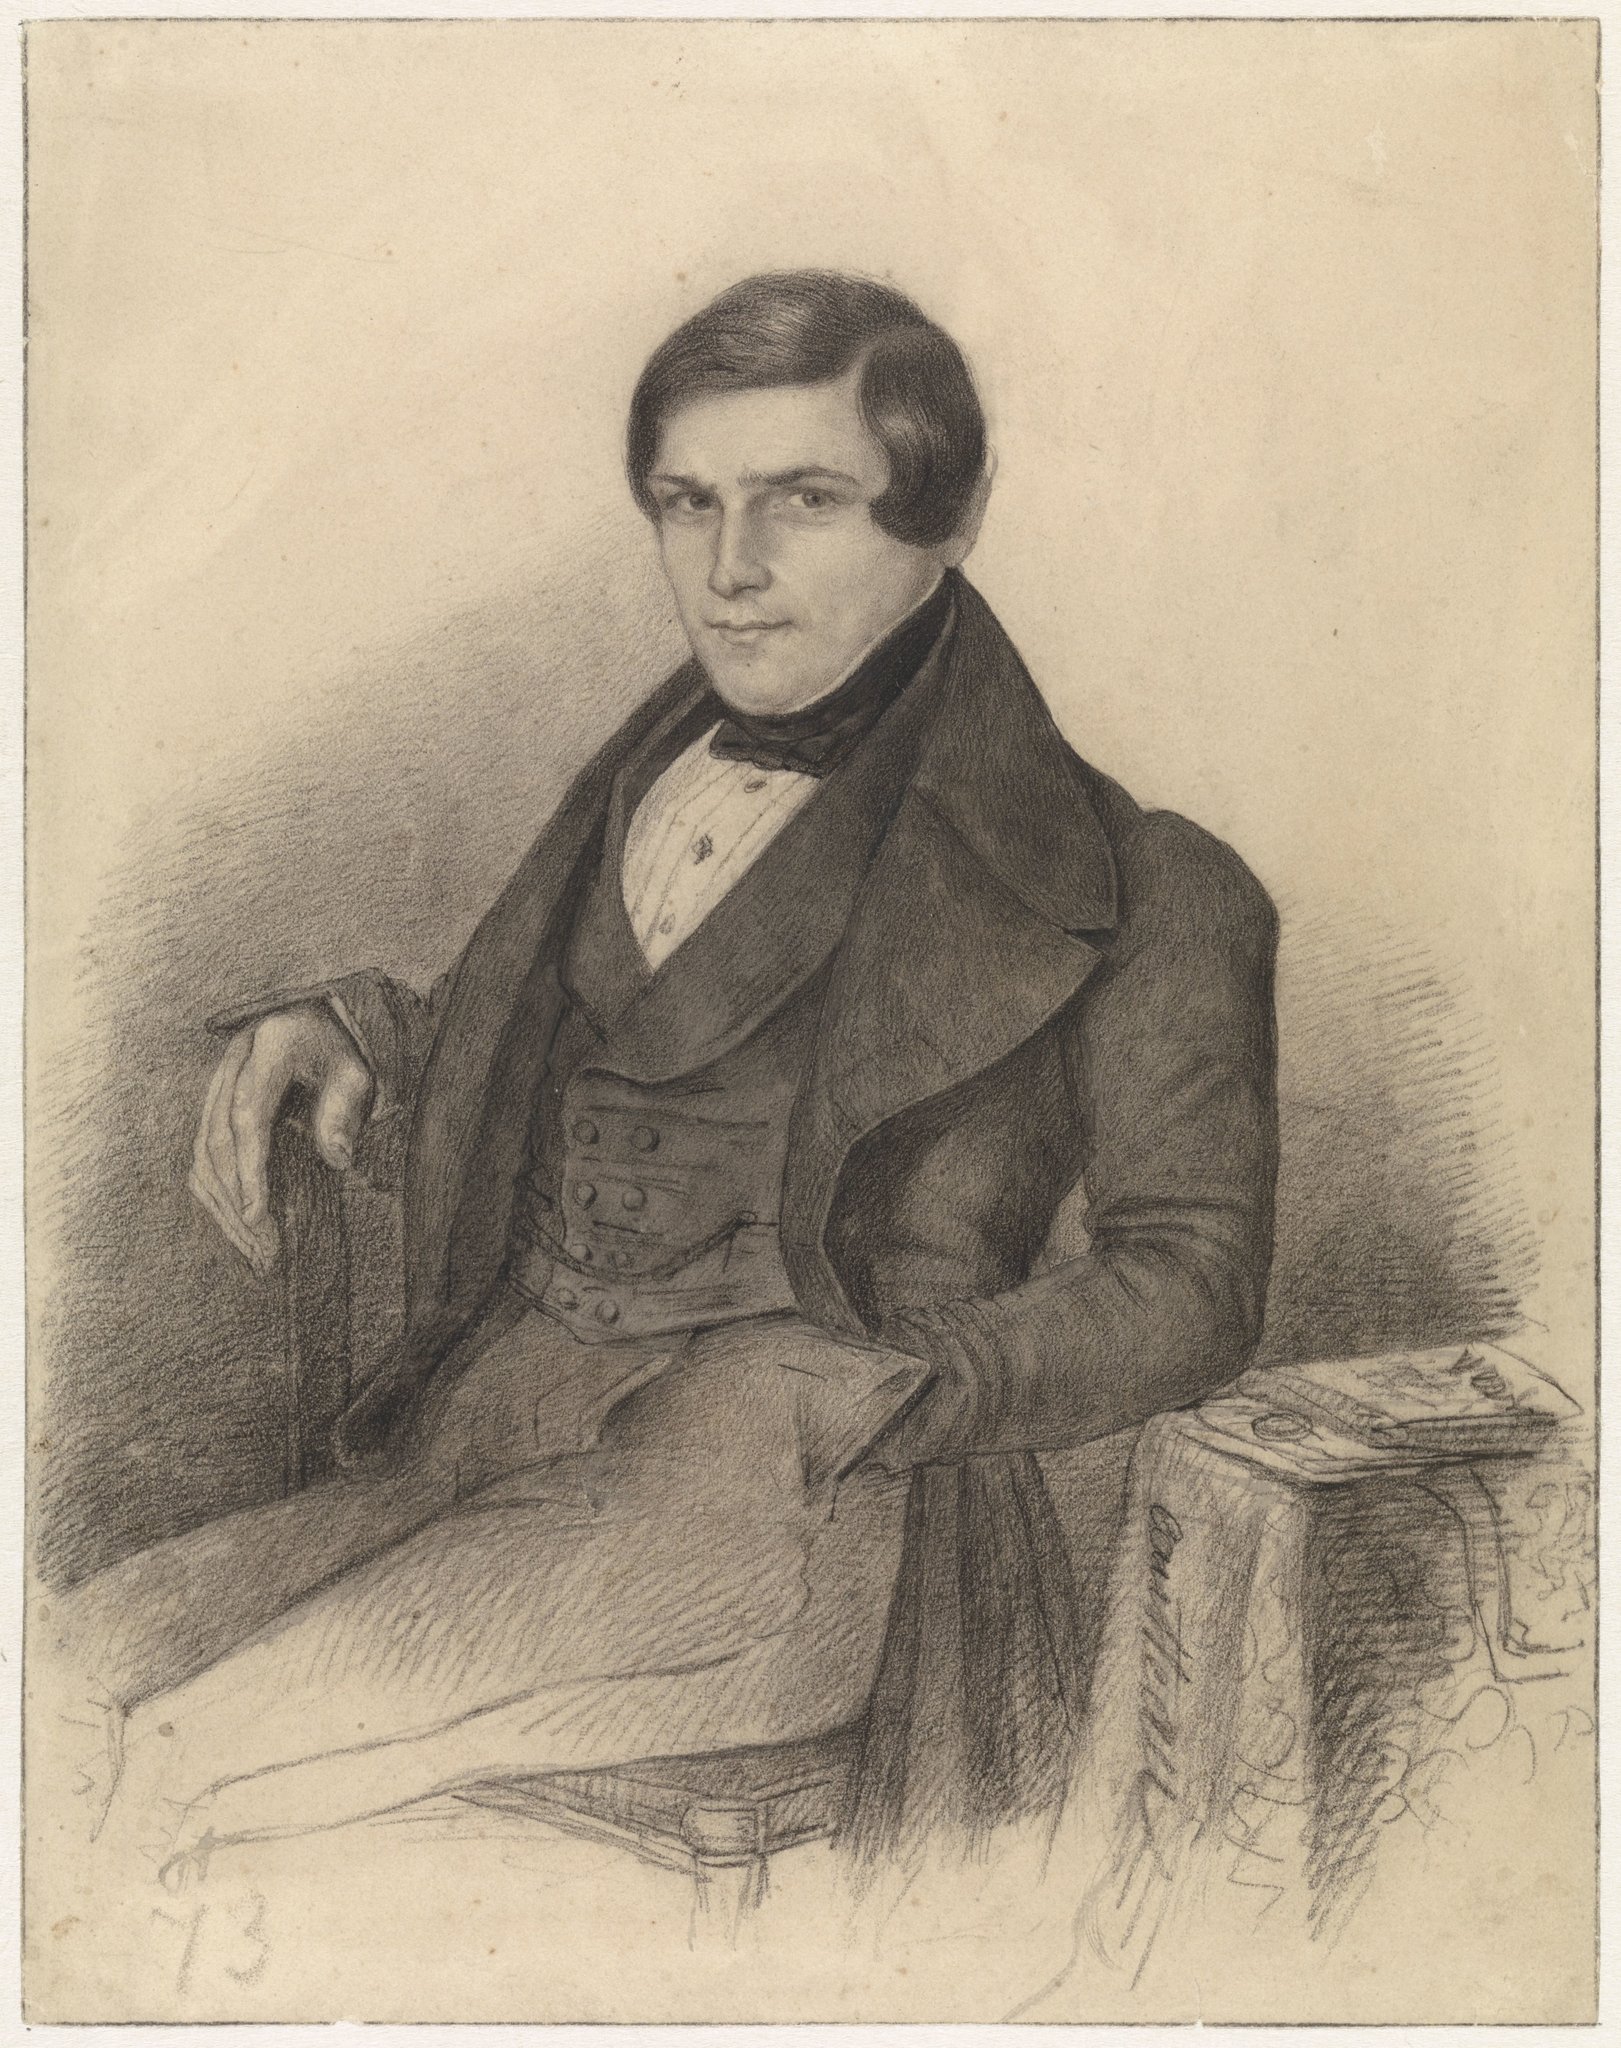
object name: drawing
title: Portret van Busken Huet (?)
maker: george coutteau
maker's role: draughtsman, print maker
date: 1800-1850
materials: chalk, paper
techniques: brush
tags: the hague, anonymous historical person portrayed alone, historical persons